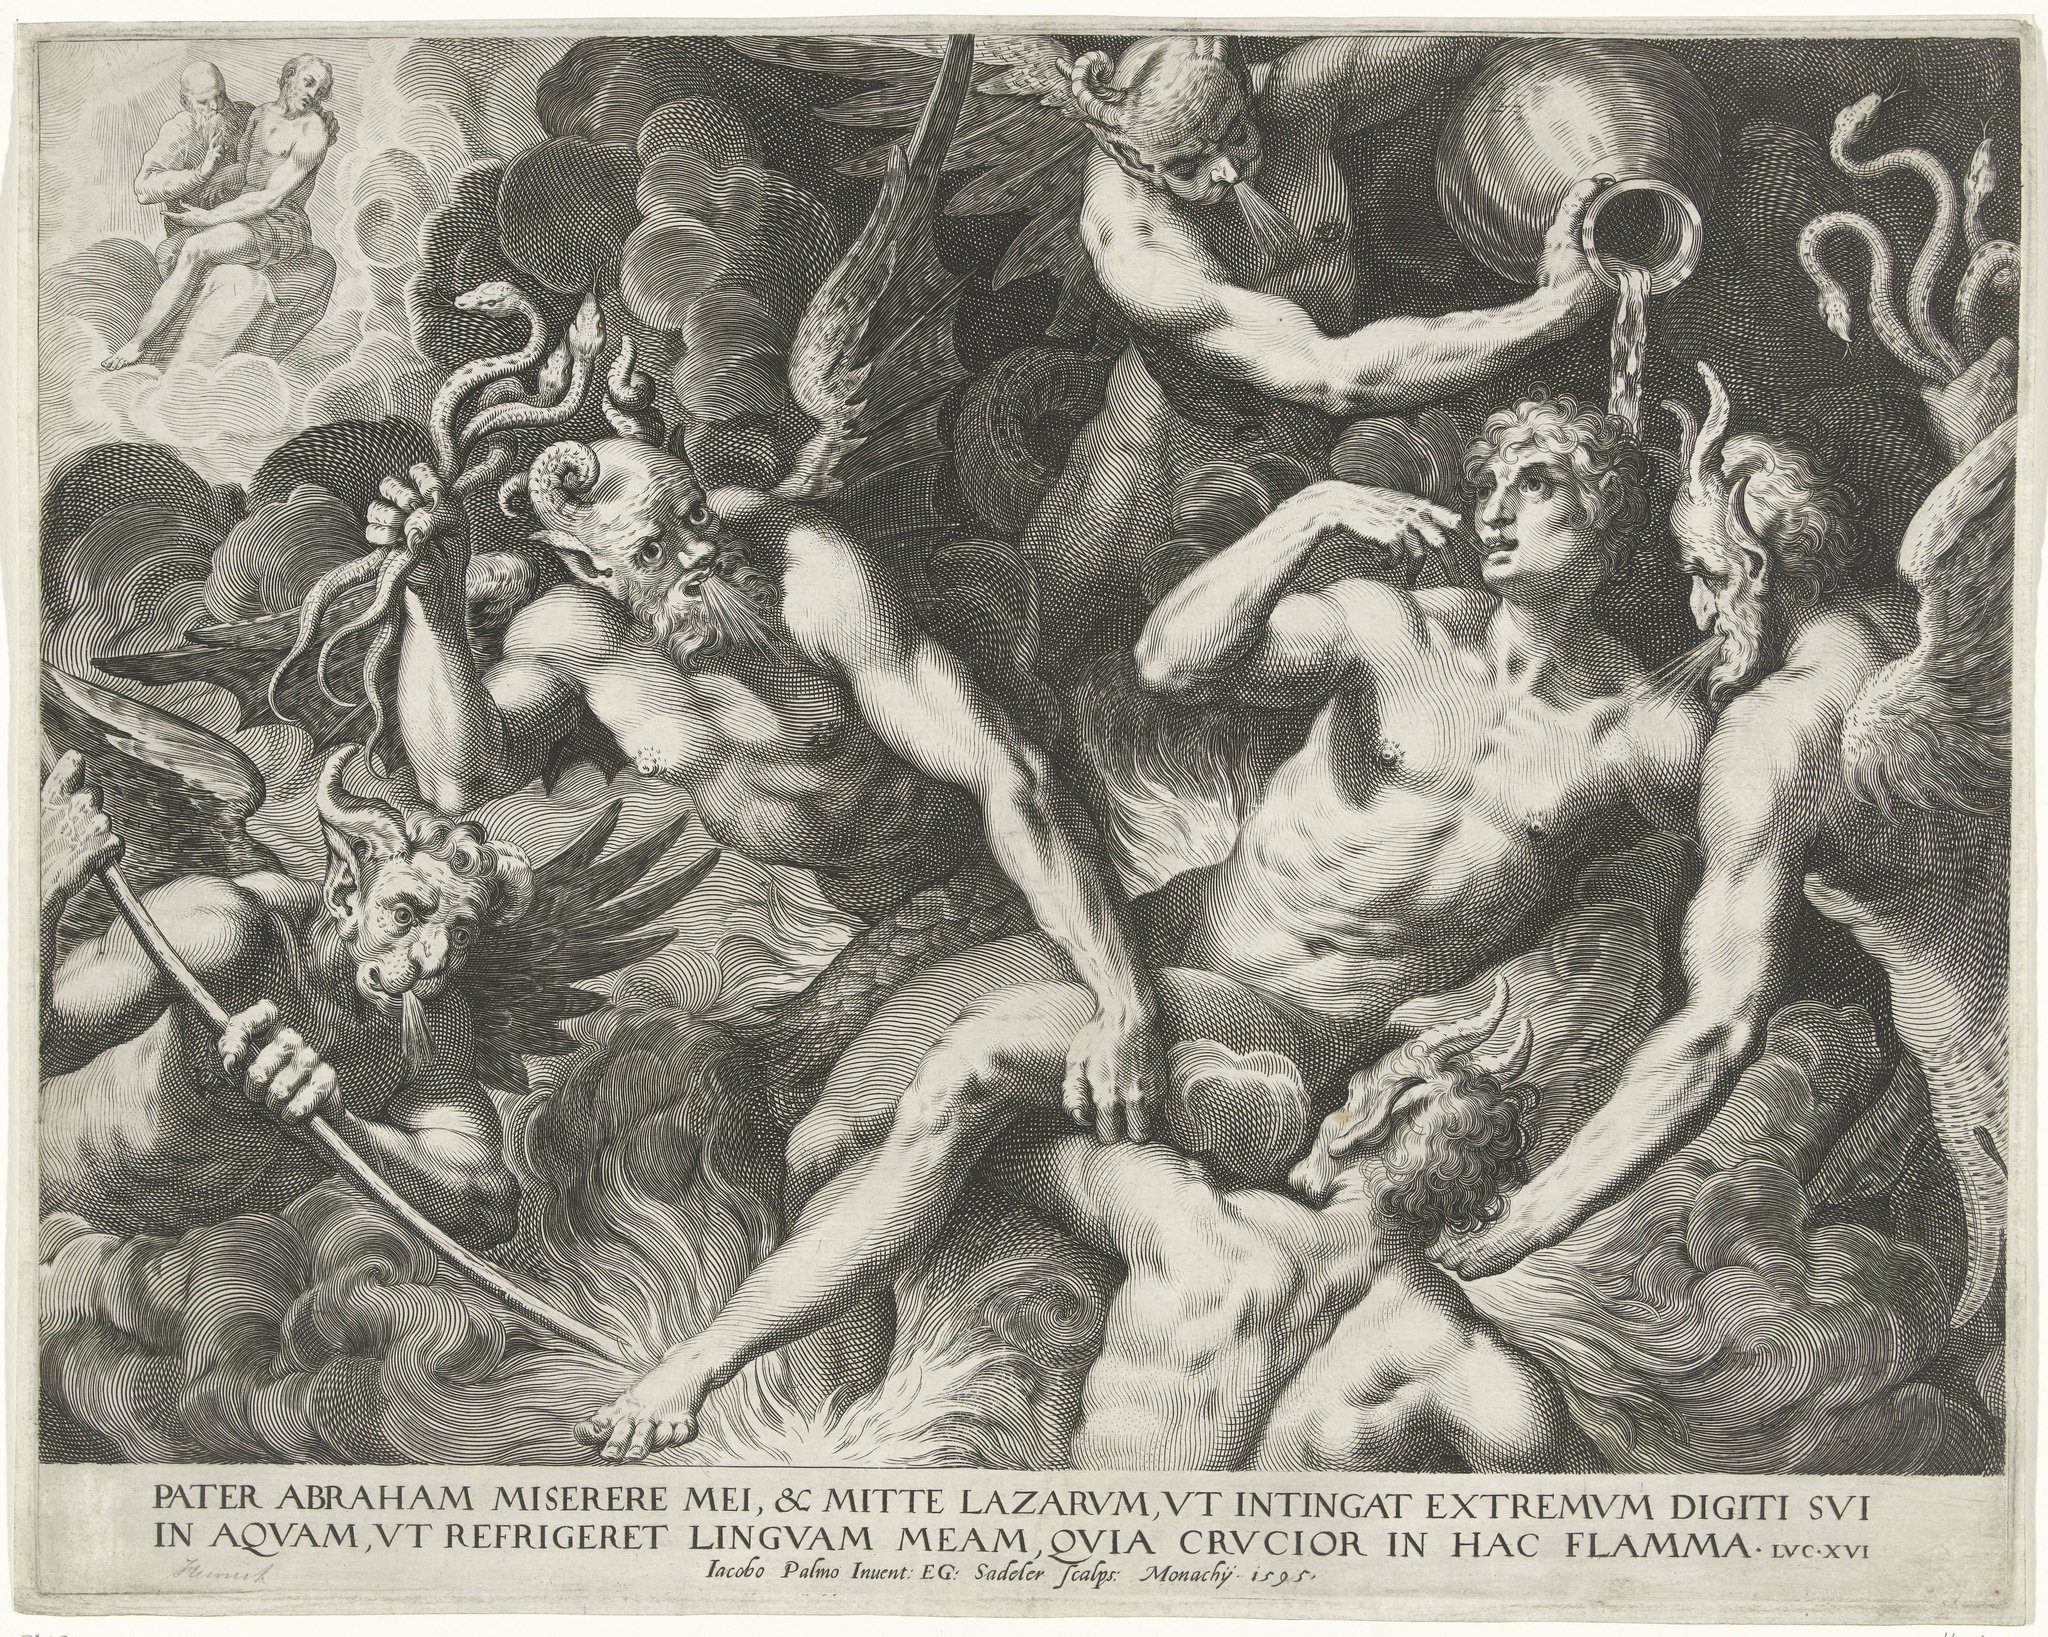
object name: print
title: Visioen van de rijke man in de hel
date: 1595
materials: paper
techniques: engraving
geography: munich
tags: dives dies; his soul is brought into hell by devils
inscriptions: collector's mark: Lugt 2760, collector's mark: Lugt 2228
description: De rijke man in de hel met demonen en duivels. In een visioen ziet hij de arme Lazarus op de schoot van Abraham. De aartsvader wijst de smeekbeden van de rijke man af met een handgebaar. De prent heeft een Latijns onderschrift uit de Bijbel (Luc. 16).